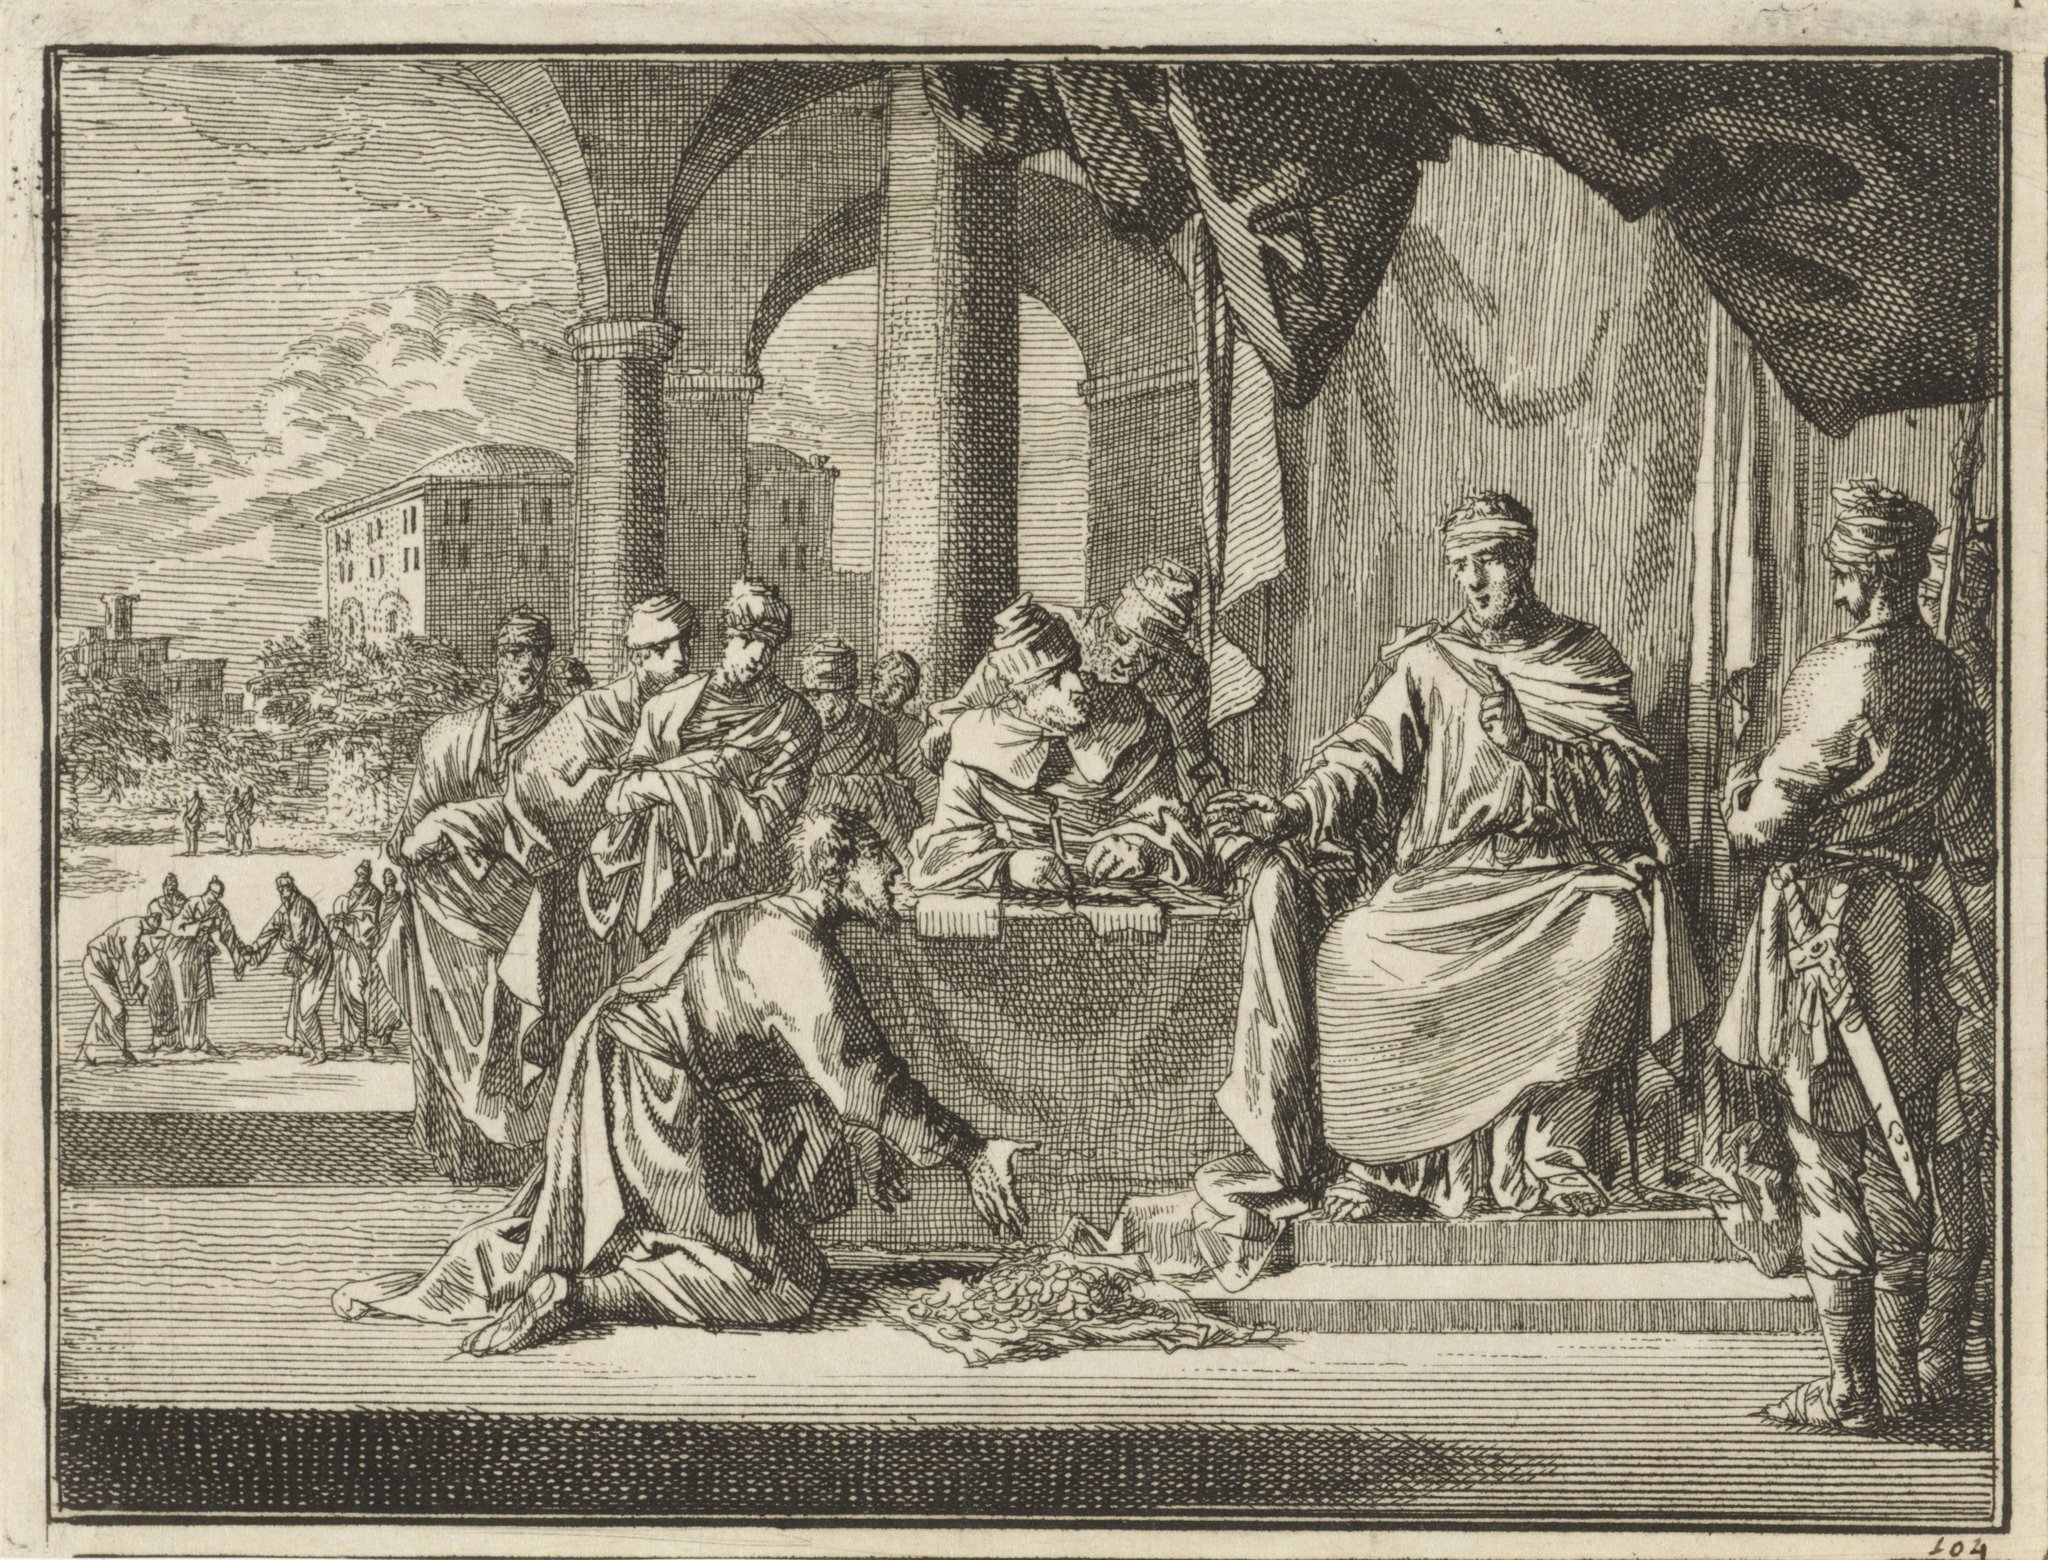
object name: print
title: Gelijkenis van de luie dienstknecht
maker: jan luyken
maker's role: draughtsman, print maker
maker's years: 1649-1712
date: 1712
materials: paper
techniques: etching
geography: amsterdam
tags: parables and proverbial sayings of christ ~ the relationship master - servant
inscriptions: number: ‘104’, collector's mark: Lugt 2228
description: Proefdruk van illustratie uit: Luyken, Jan. De schriftuurlyke geschiedenissen en gelykenissen van het Oude en Nieuwe Verbond, 2 delen. Amsterdam: Wed. Pieter Arentsz II en Cornelis van der Sys, 1712, dl. II.